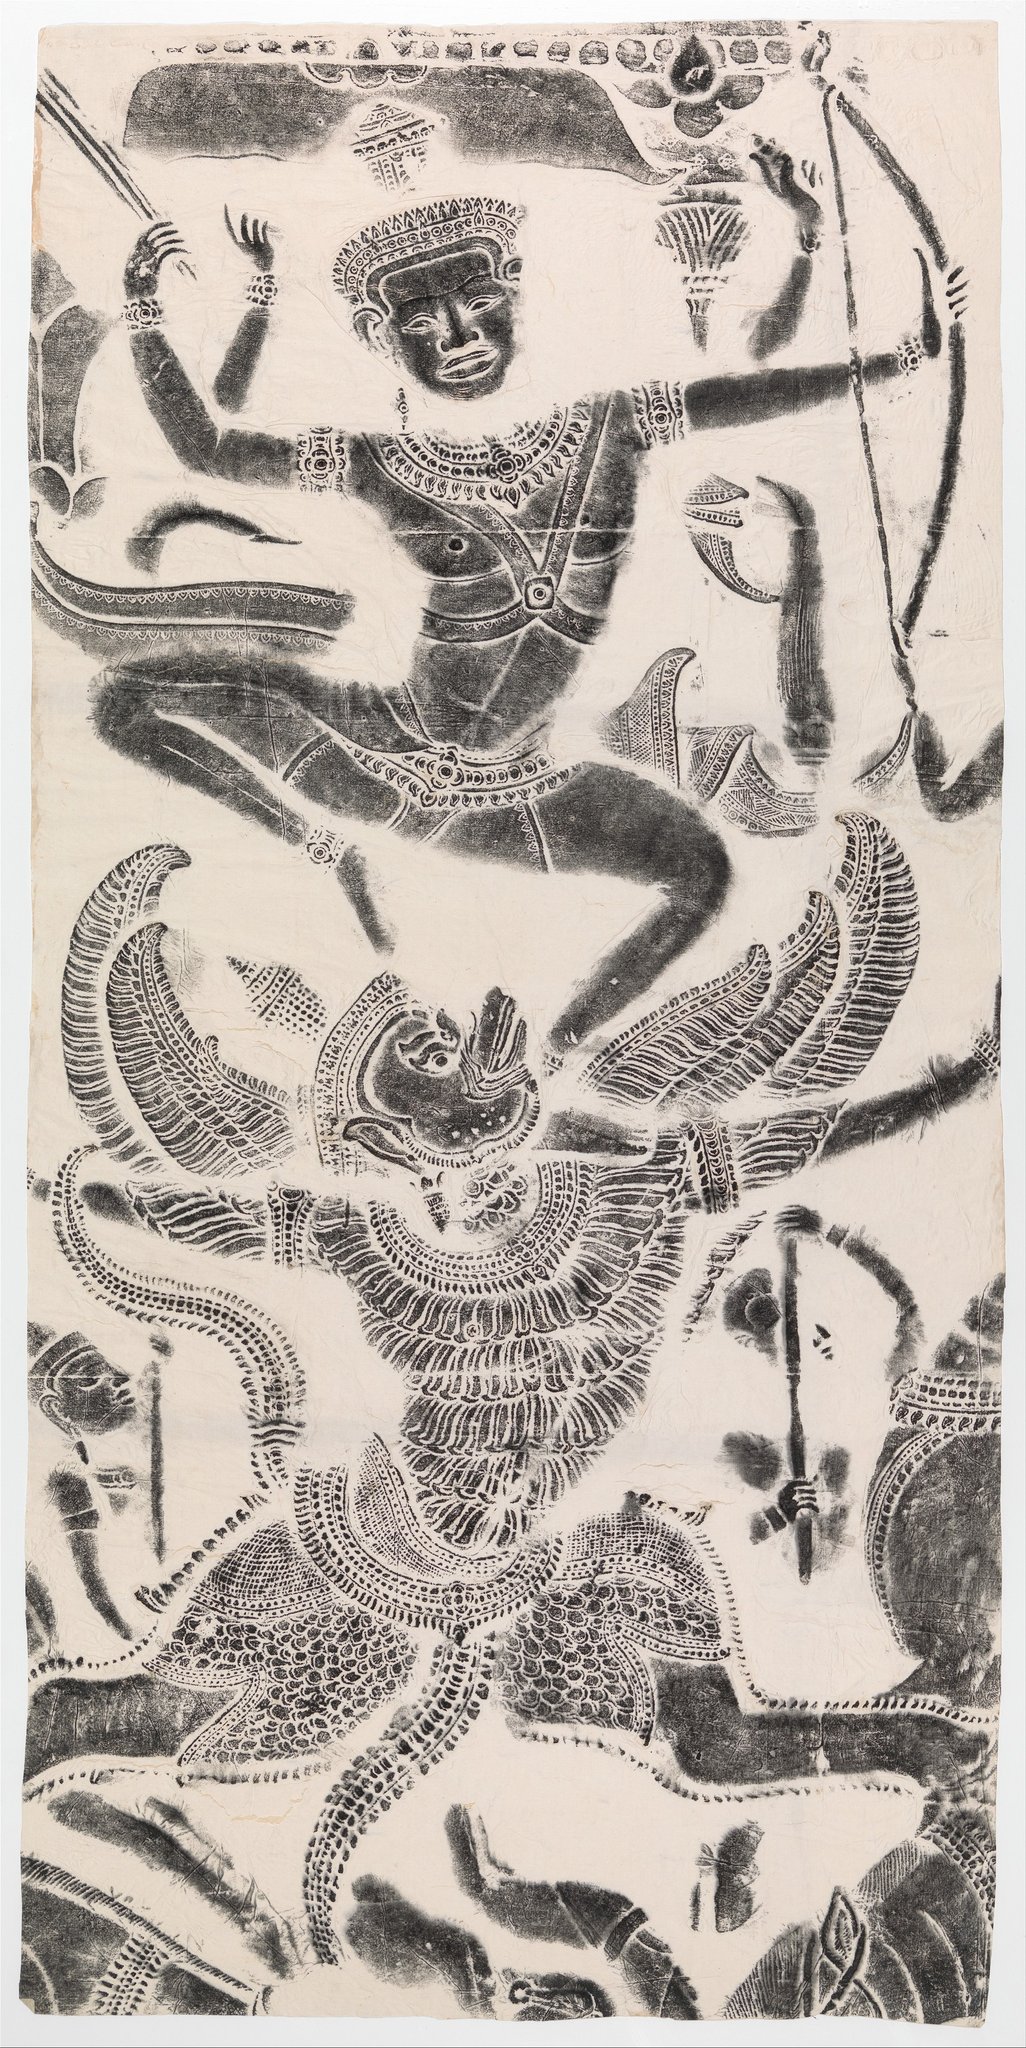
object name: rubbing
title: Rubbing of a Scene from the Ramayana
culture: cambodian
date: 1901-2000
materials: ink, paper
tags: bow and arrow